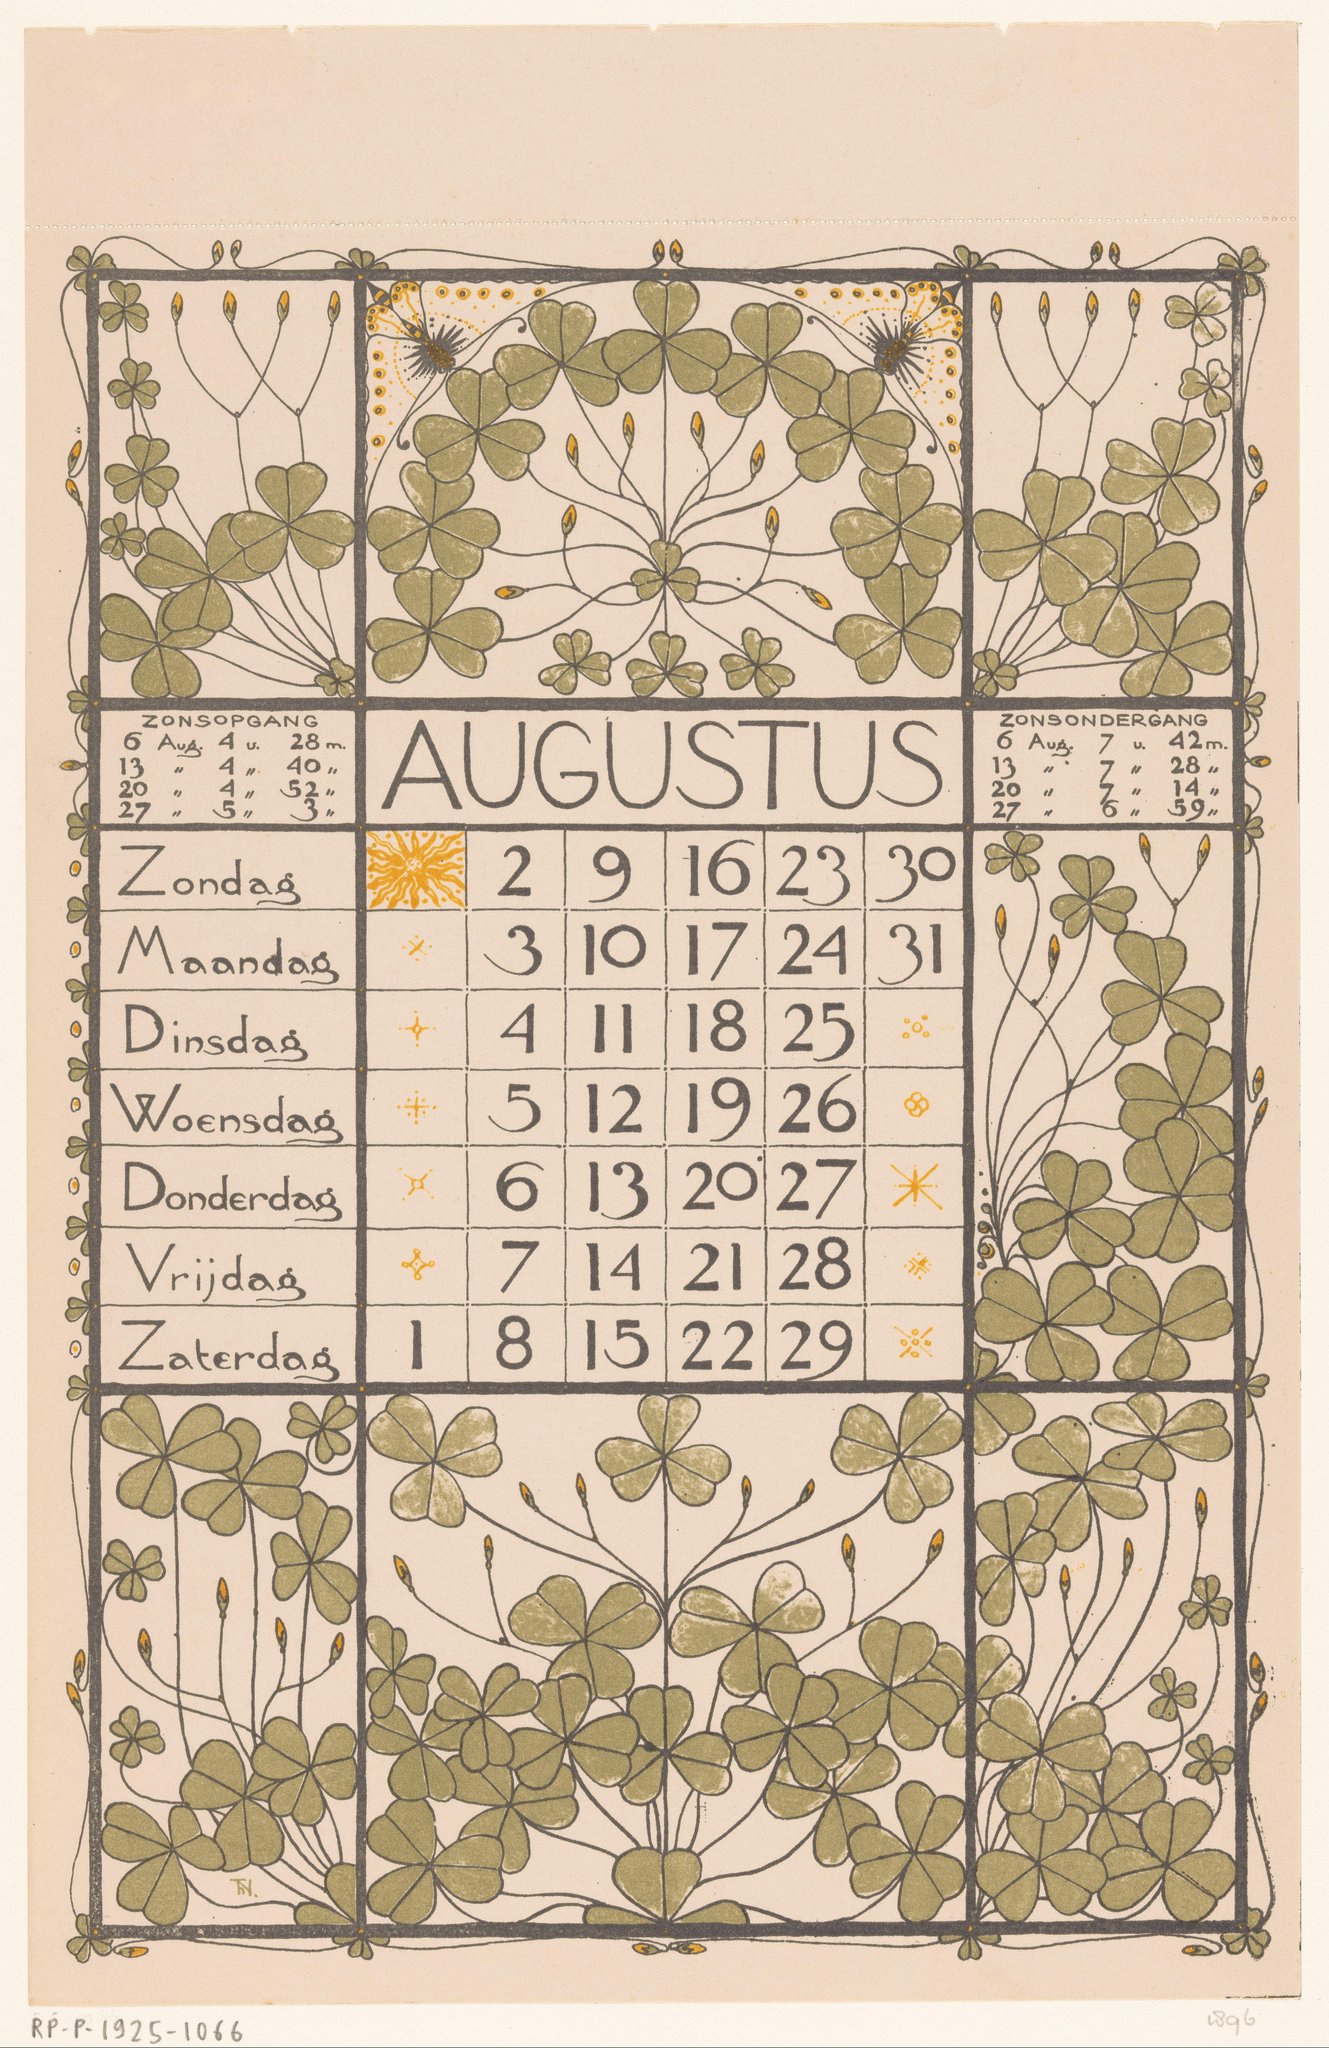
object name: print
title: Kalenderblad voor augustus 1896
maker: theo nieuwenhuis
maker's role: designer, draughtsman, print maker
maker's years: 1866-1951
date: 1895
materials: paper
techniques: lithograph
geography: amsterdam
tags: plants and herbs: clover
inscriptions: collector's mark: Lugt 2228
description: Een rechthoekig kader met de dagen van de maand augustus en informatie over de zonsopgang en zonsondergang in augustus, met daaromheen klaver.